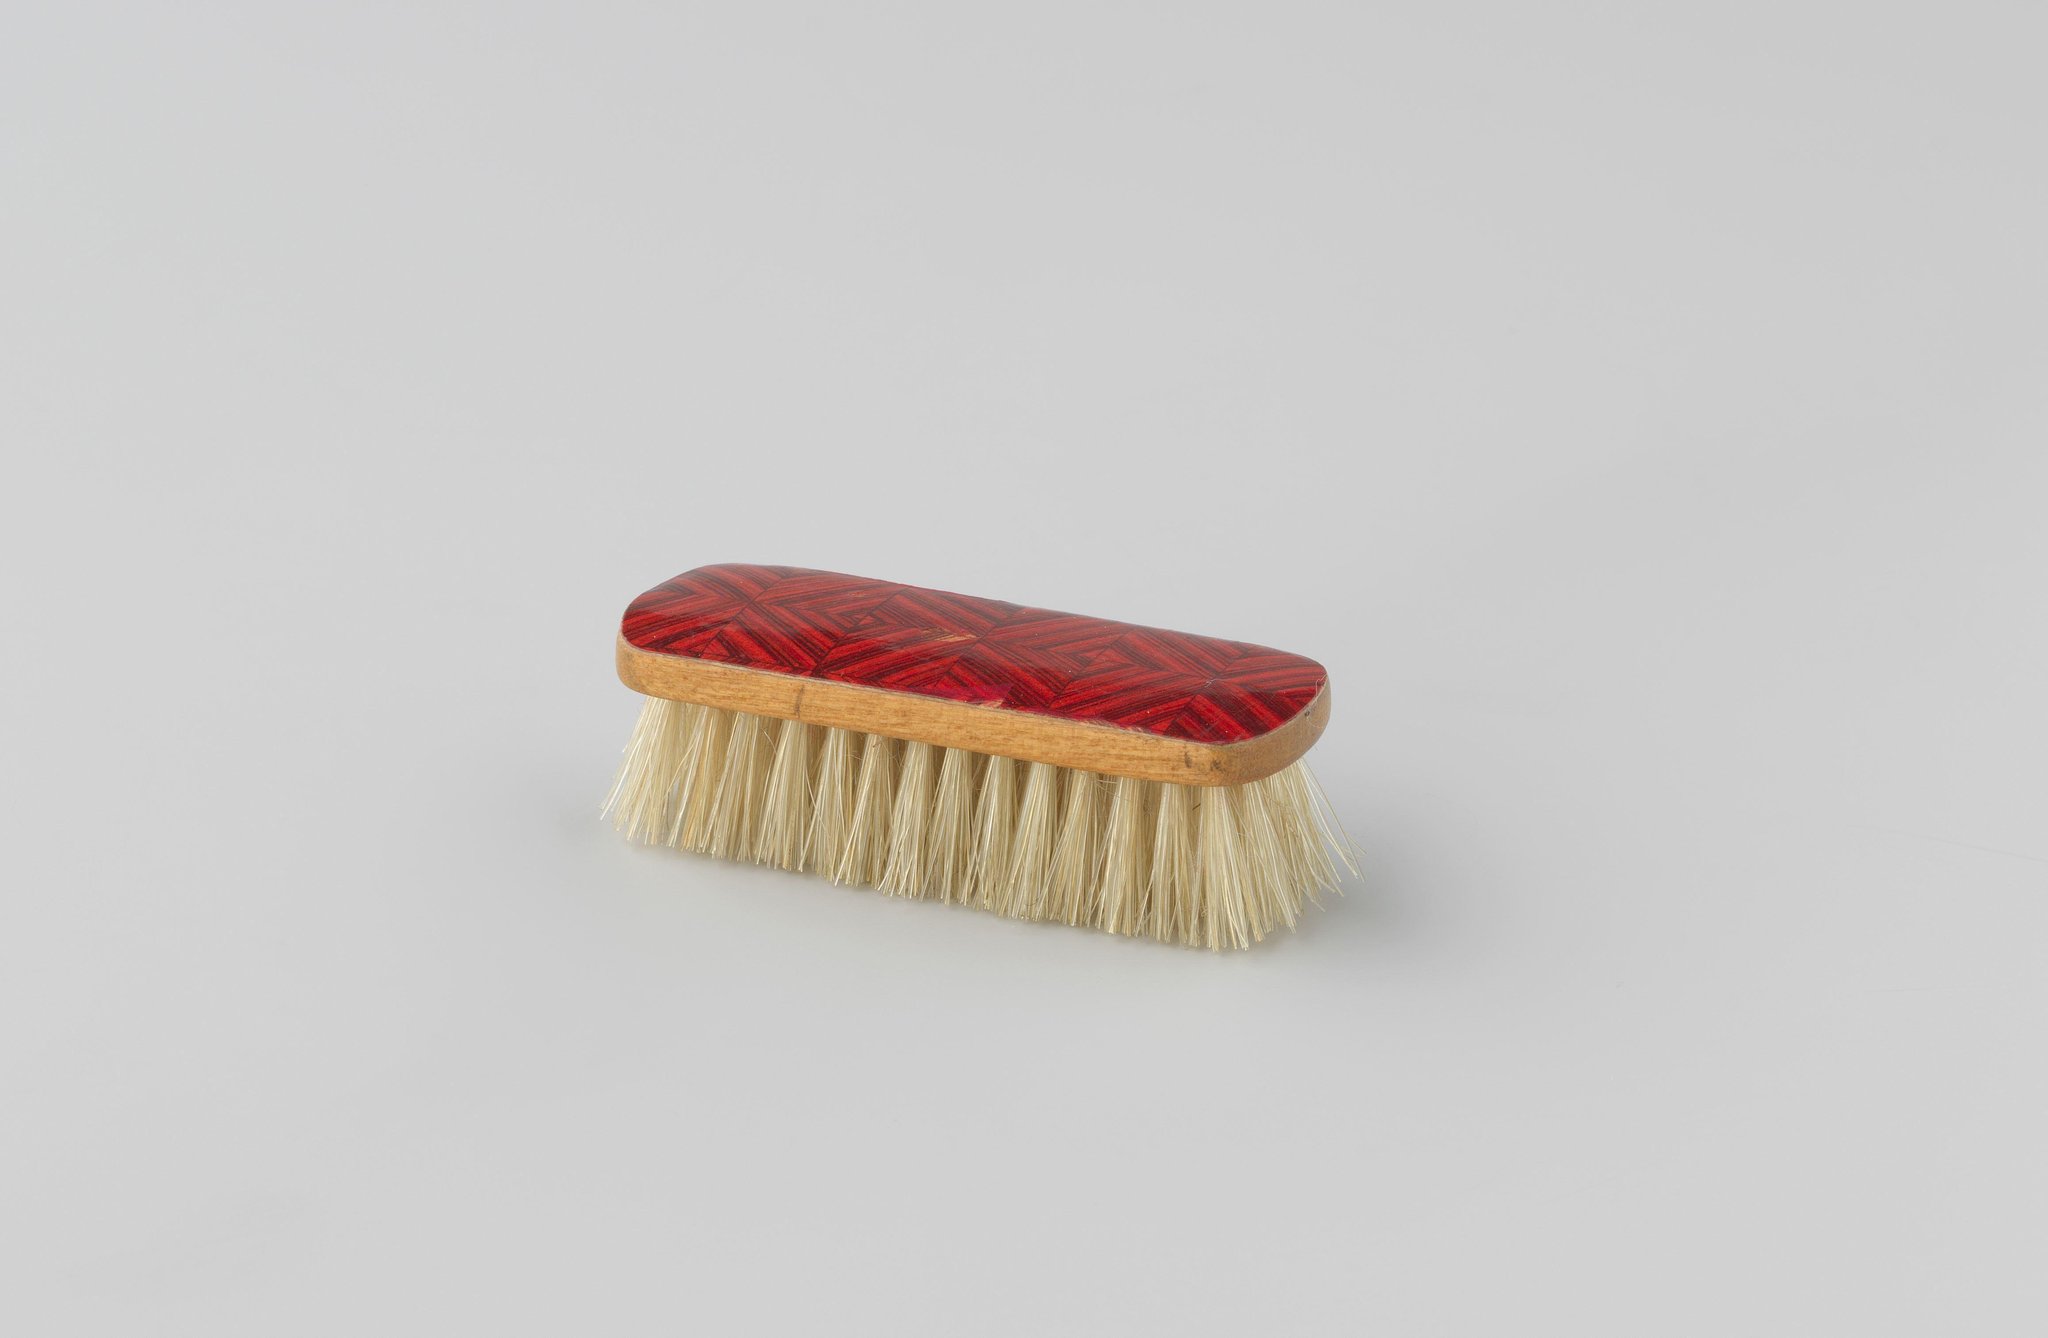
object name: clothes brush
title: Kledingborstel van hout met haar. Onderzijde rood met ruitmotief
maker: Anonymous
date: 1880-1890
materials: hair, wood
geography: netherlands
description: Kledingborstel van hout met haar. Onderzijde rood met ruitmotief.